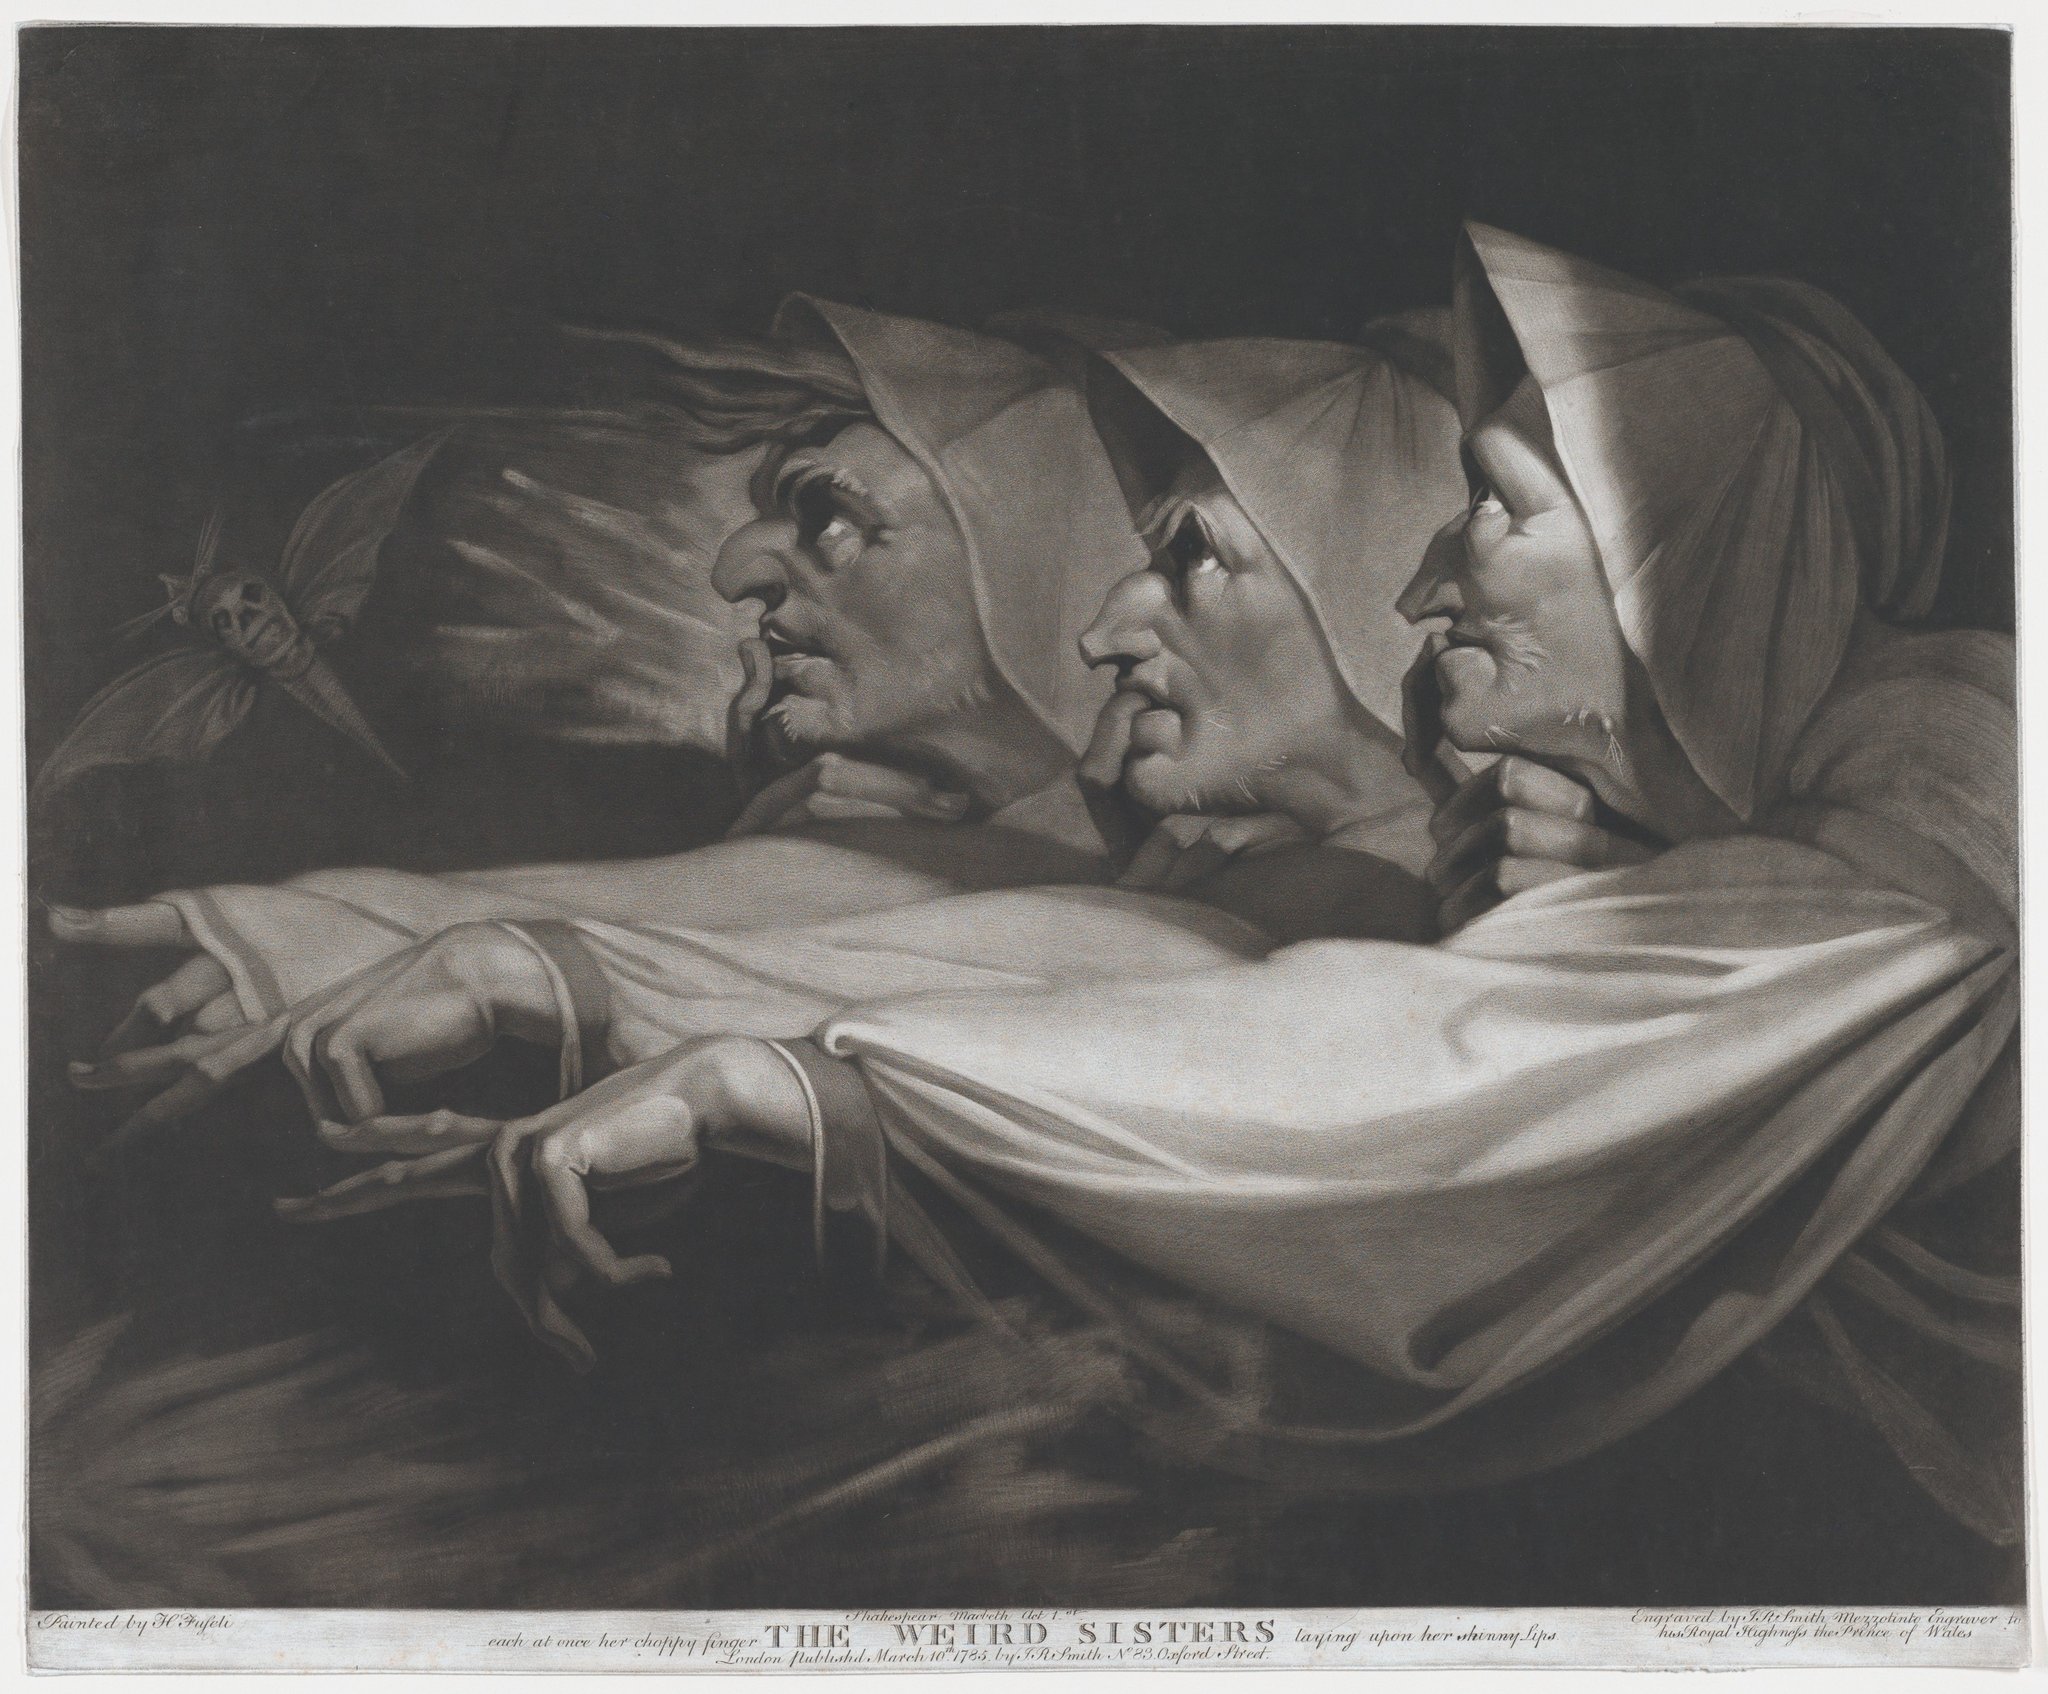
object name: print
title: The Weird Sisters (Shakespeare, MacBeth, Act 1, Scene 3)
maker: john raphael smith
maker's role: engraver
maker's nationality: british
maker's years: 1751-1812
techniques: mezzotint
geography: london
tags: shakespeare,women,witches,macbeth